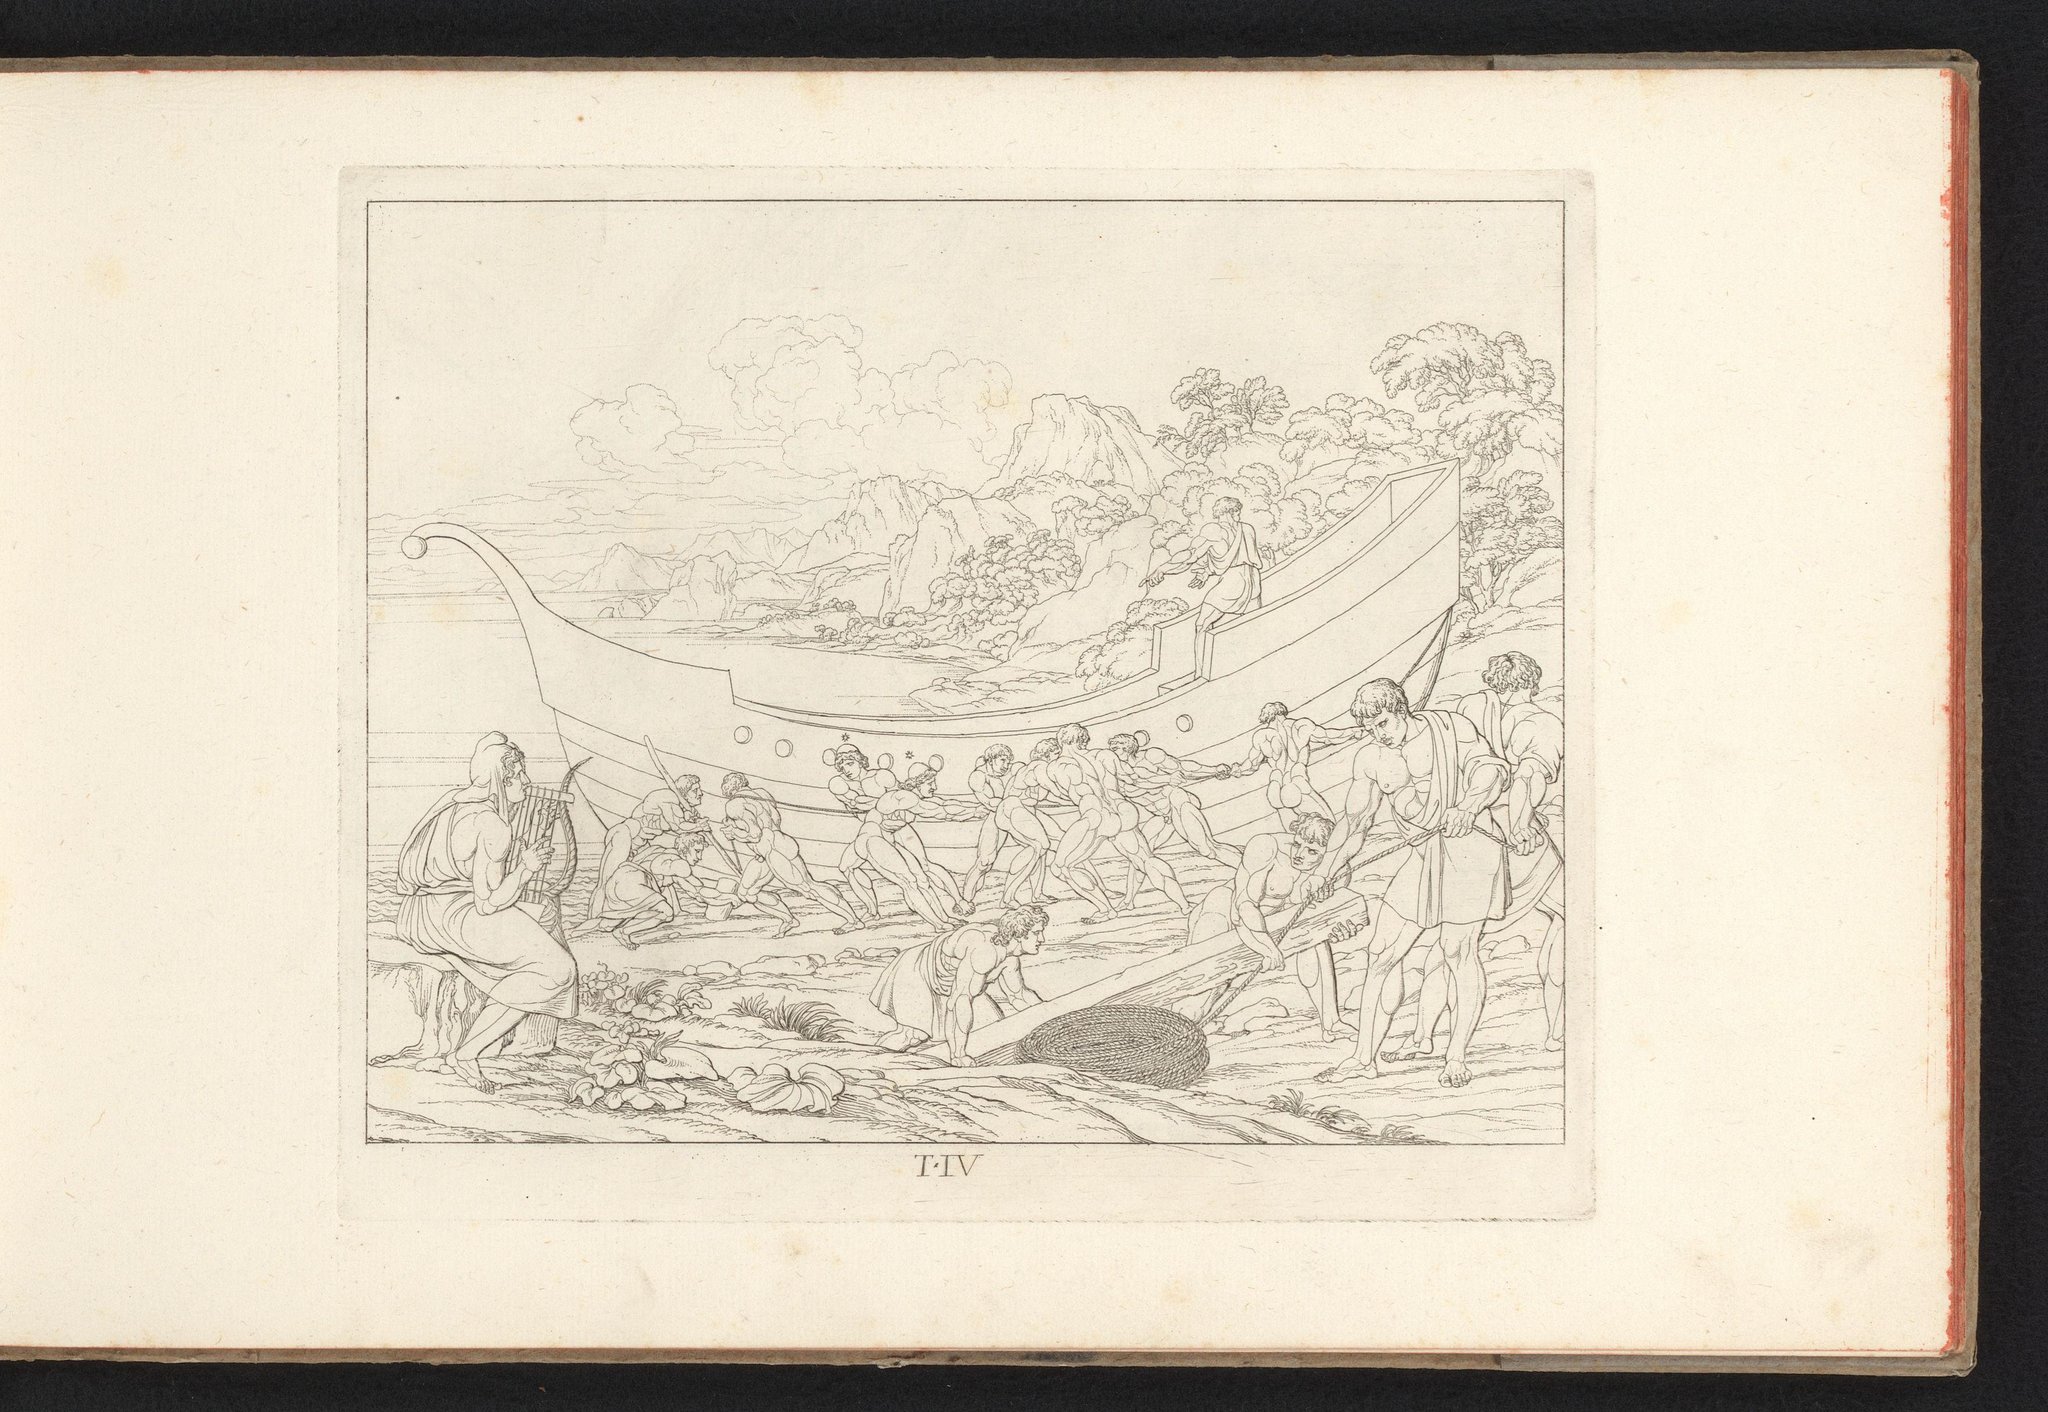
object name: album leaf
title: Bouw van het schip Argo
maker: joseph anton koch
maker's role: draughtsman, painter, print maker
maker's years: 1768-1839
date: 1799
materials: paper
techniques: etching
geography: rome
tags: the argo is built, sometimes with assistance of minerva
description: Deze prent maakt deel uit van een serie met 24 prenten.